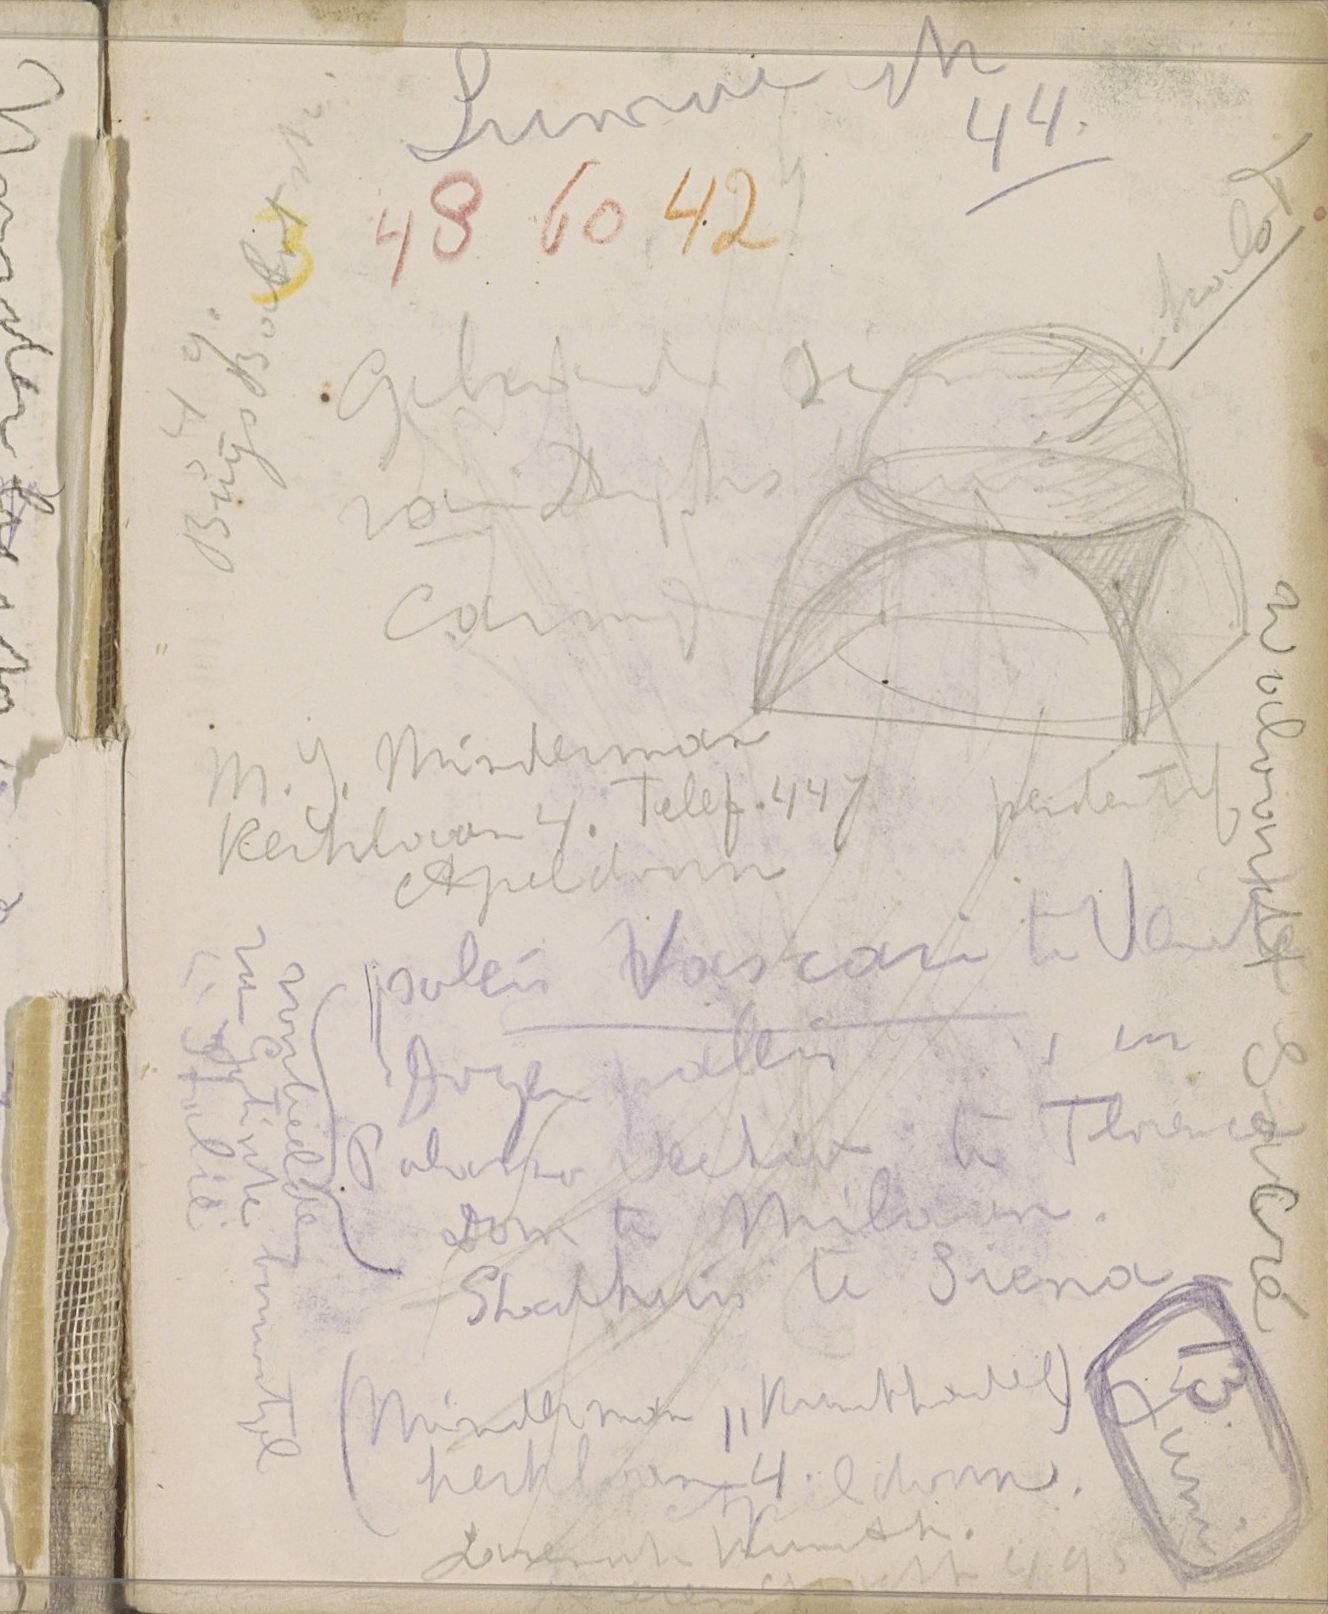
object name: sketchbook leaf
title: Koepeldak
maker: reijer stolk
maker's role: draughtsman, print maker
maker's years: 1896-1945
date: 1916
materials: paper, pencil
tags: dome ~ architecture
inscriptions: annotation: ‘[...]’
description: Blad 1 recto uit een schetsboek met 72 bladen.